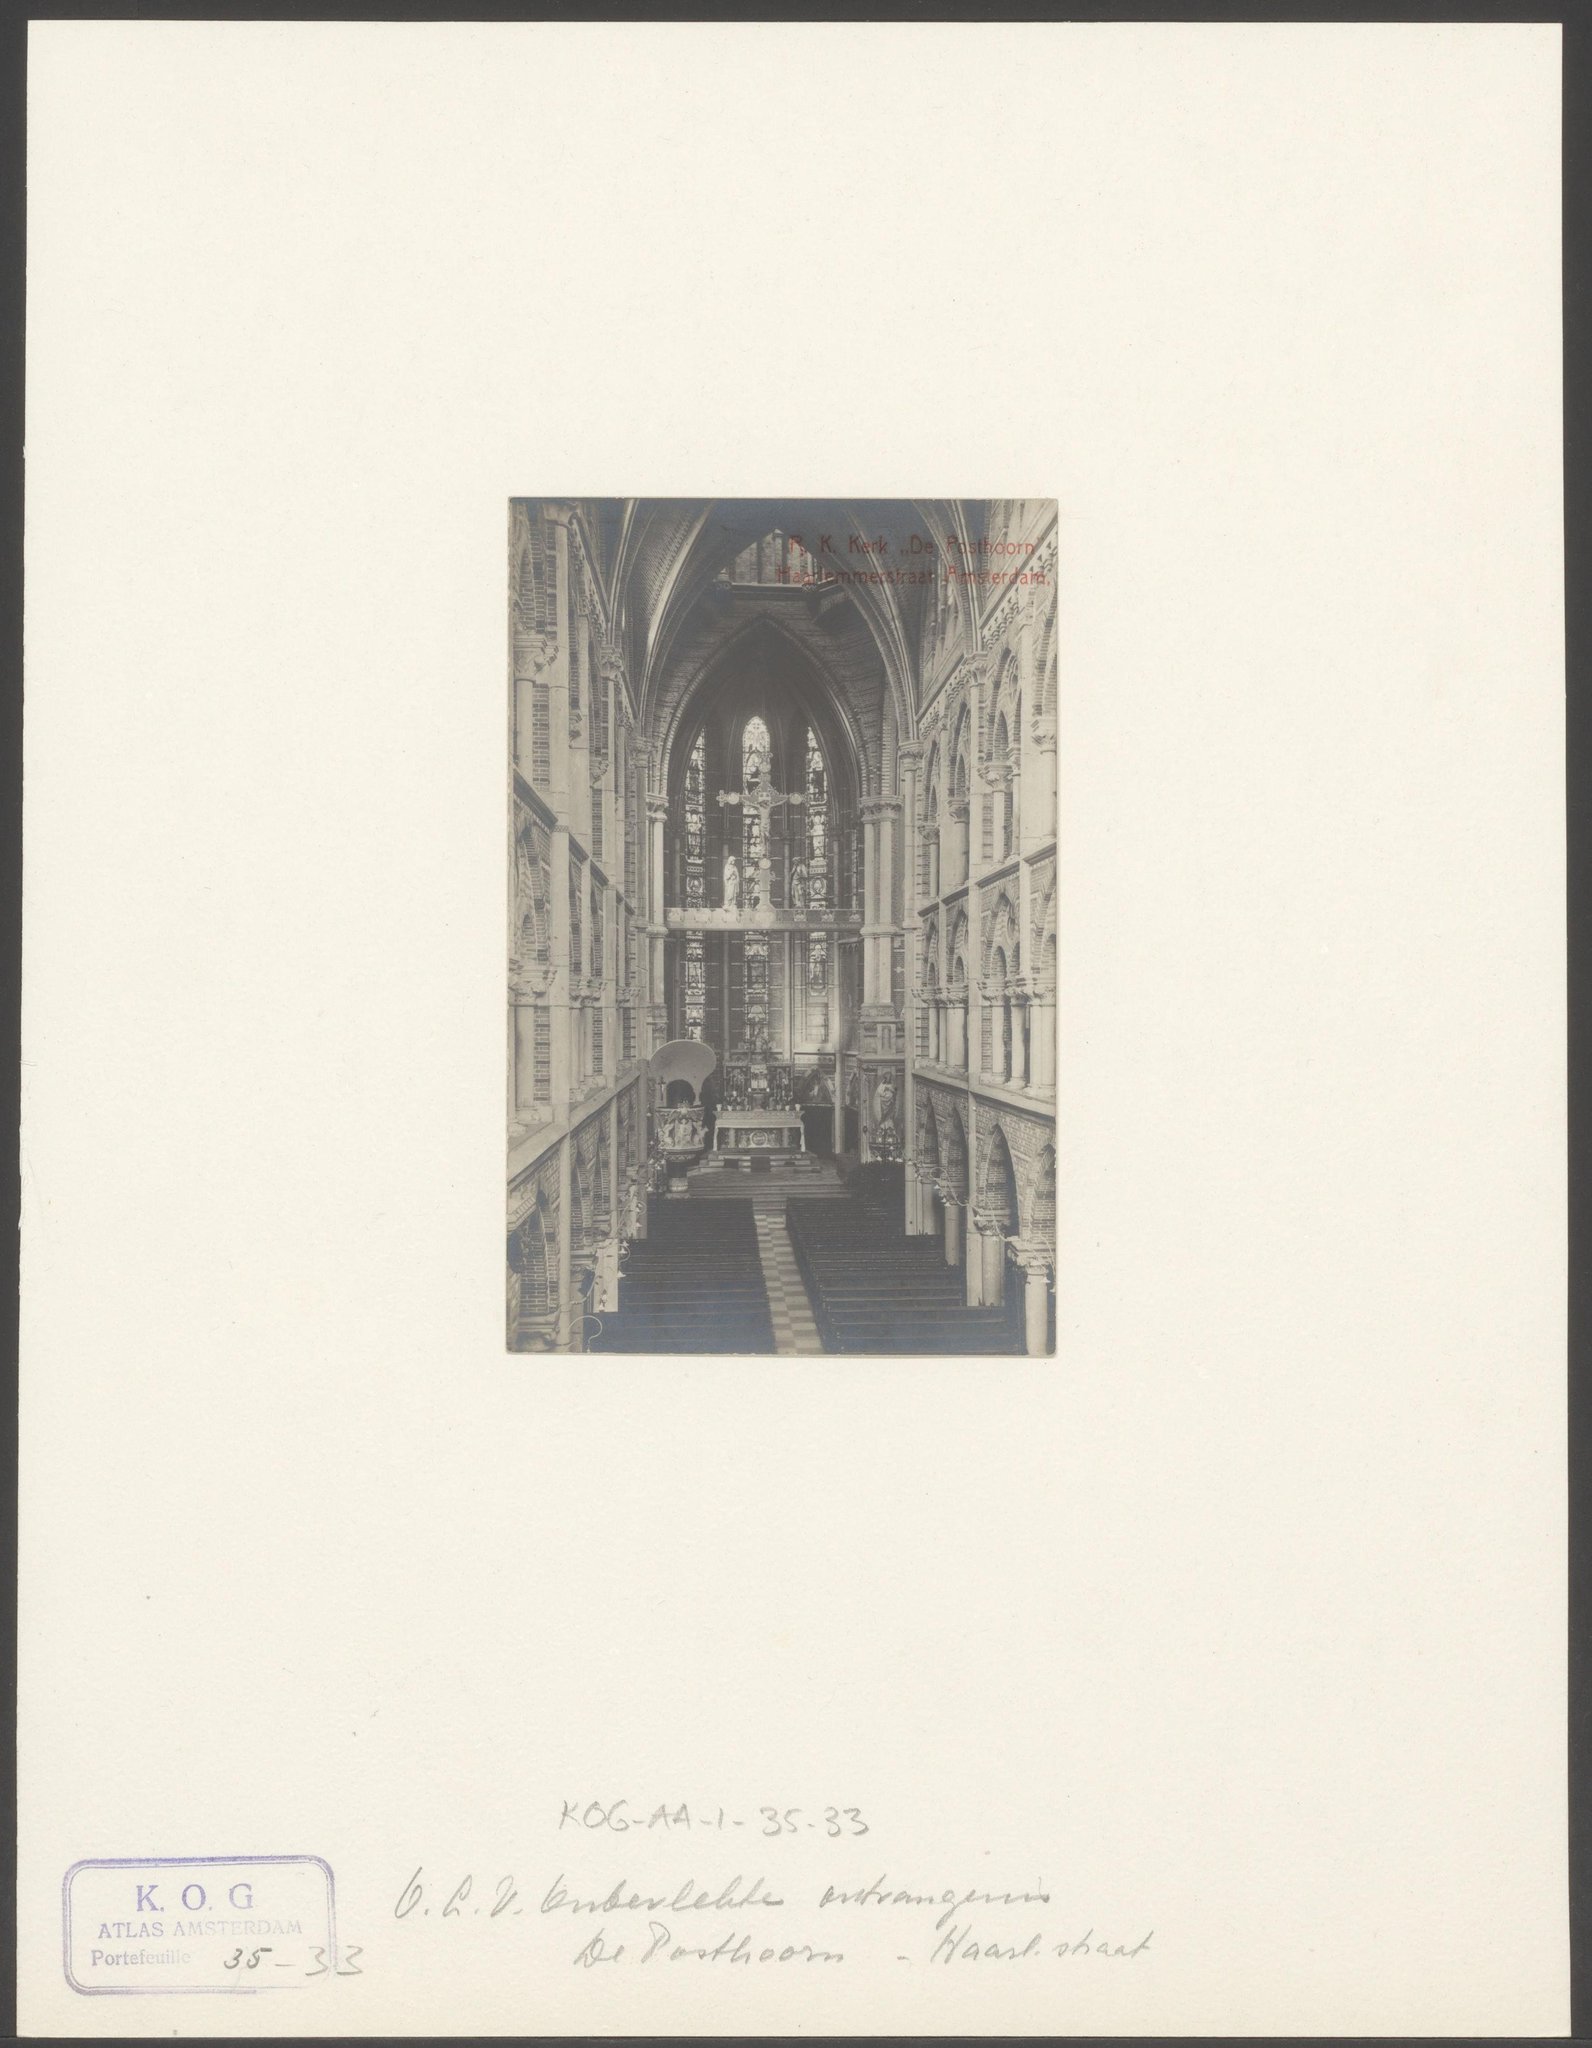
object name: ansichtkaart, prentbriefkaart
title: Gezicht op het interieur van de Posthoornkerk te Amsterdam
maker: Anonymous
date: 1900-1930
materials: paper, cardboard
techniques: gelatin silver print, letterpress printing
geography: amsterdam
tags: parts of church interior: aisle, regular clerics, e.g. jesuits, redemptorists, fixed altar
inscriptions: collector's mark: ‘17’ Lugt 1641b, collector's mark: ‘35-33’ Lugt 1641b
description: Onderwerpsrubriek binnen de Atlas Amsterdam: R.K. Gemeenten: Sint Nicolaaskerk t/m Willibrordus (Rustenburgerstraat).